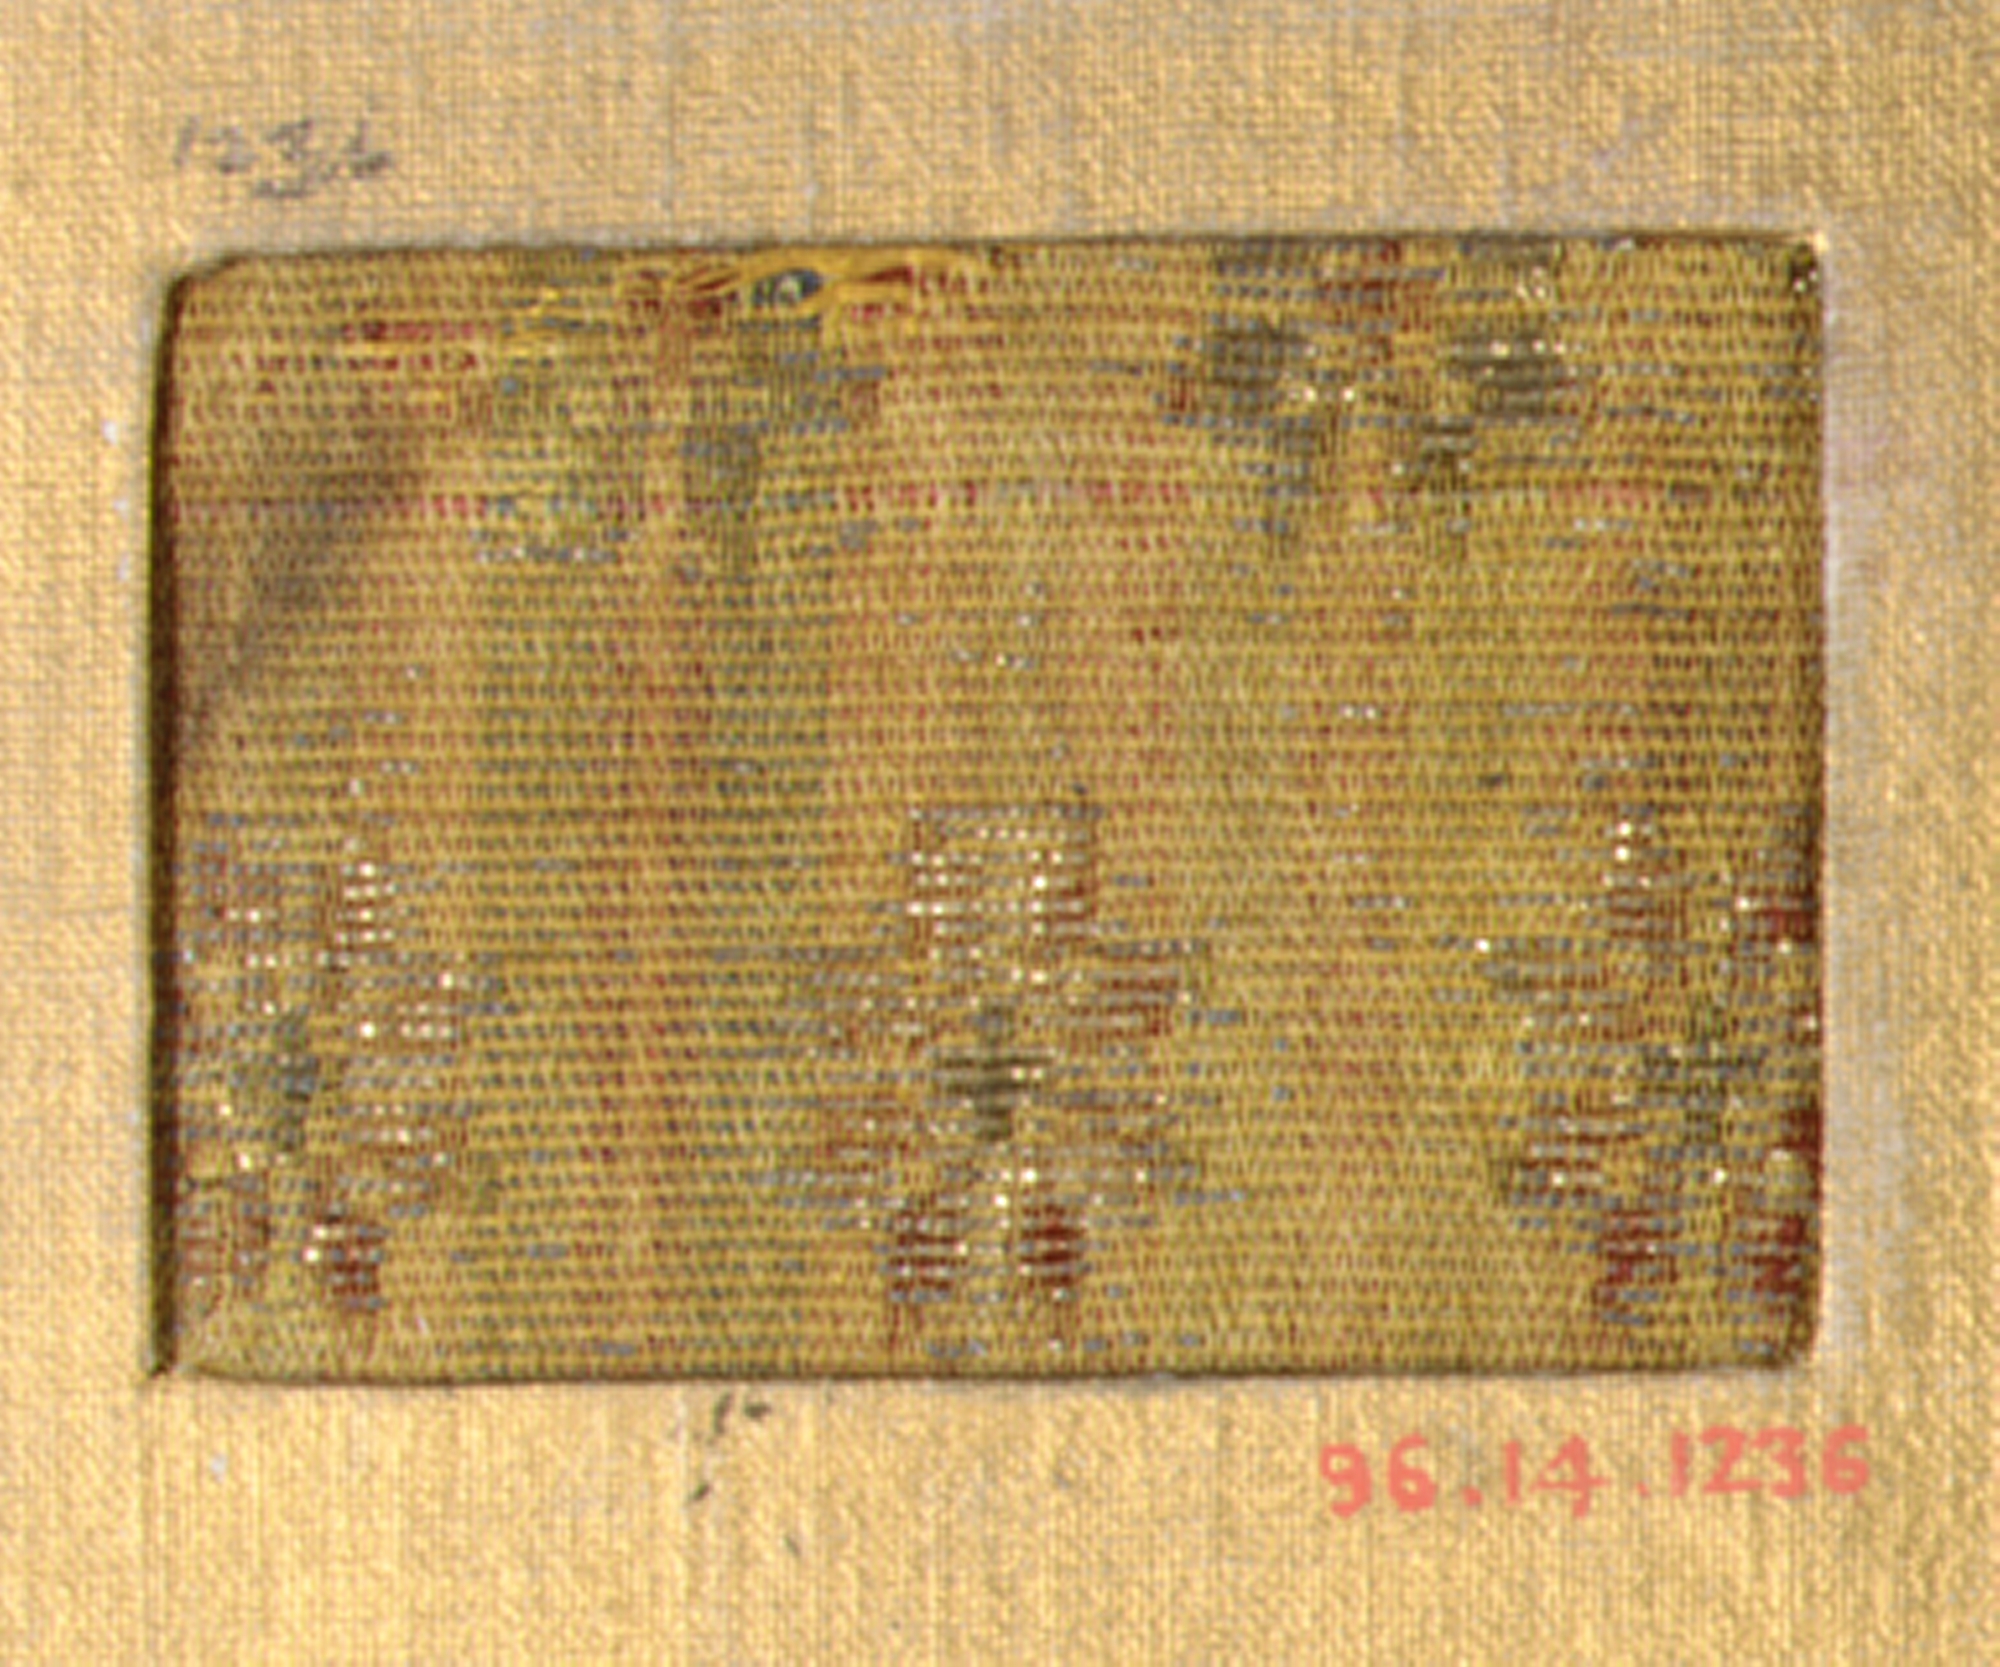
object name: piece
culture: japanese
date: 1701-1900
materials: silk